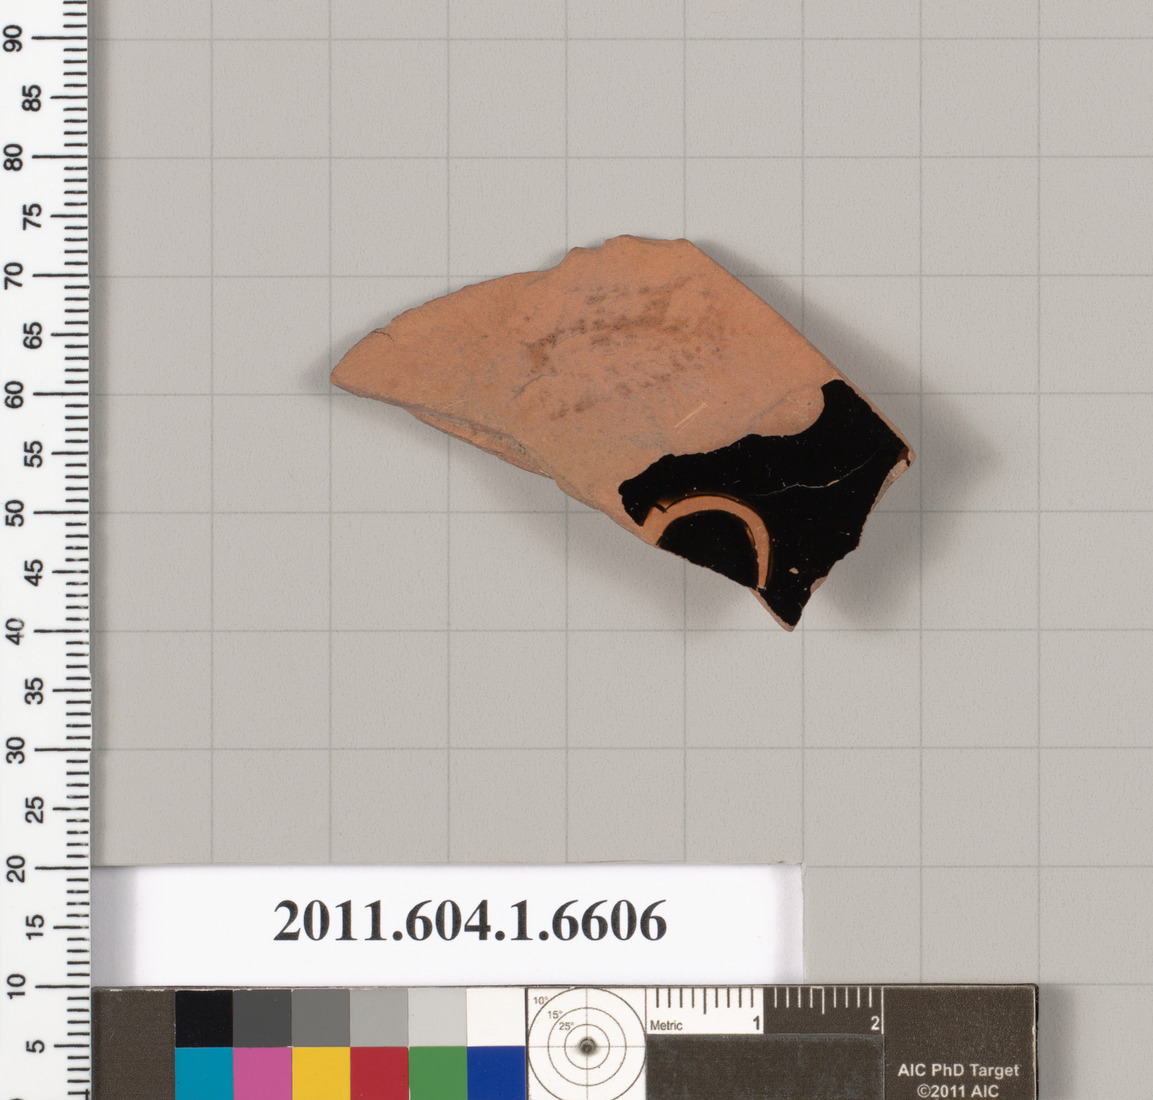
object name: kylix fragment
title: Terracotta fragment of a kylix (drinking cup)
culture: greek, attic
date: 490-480 BCE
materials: terracotta